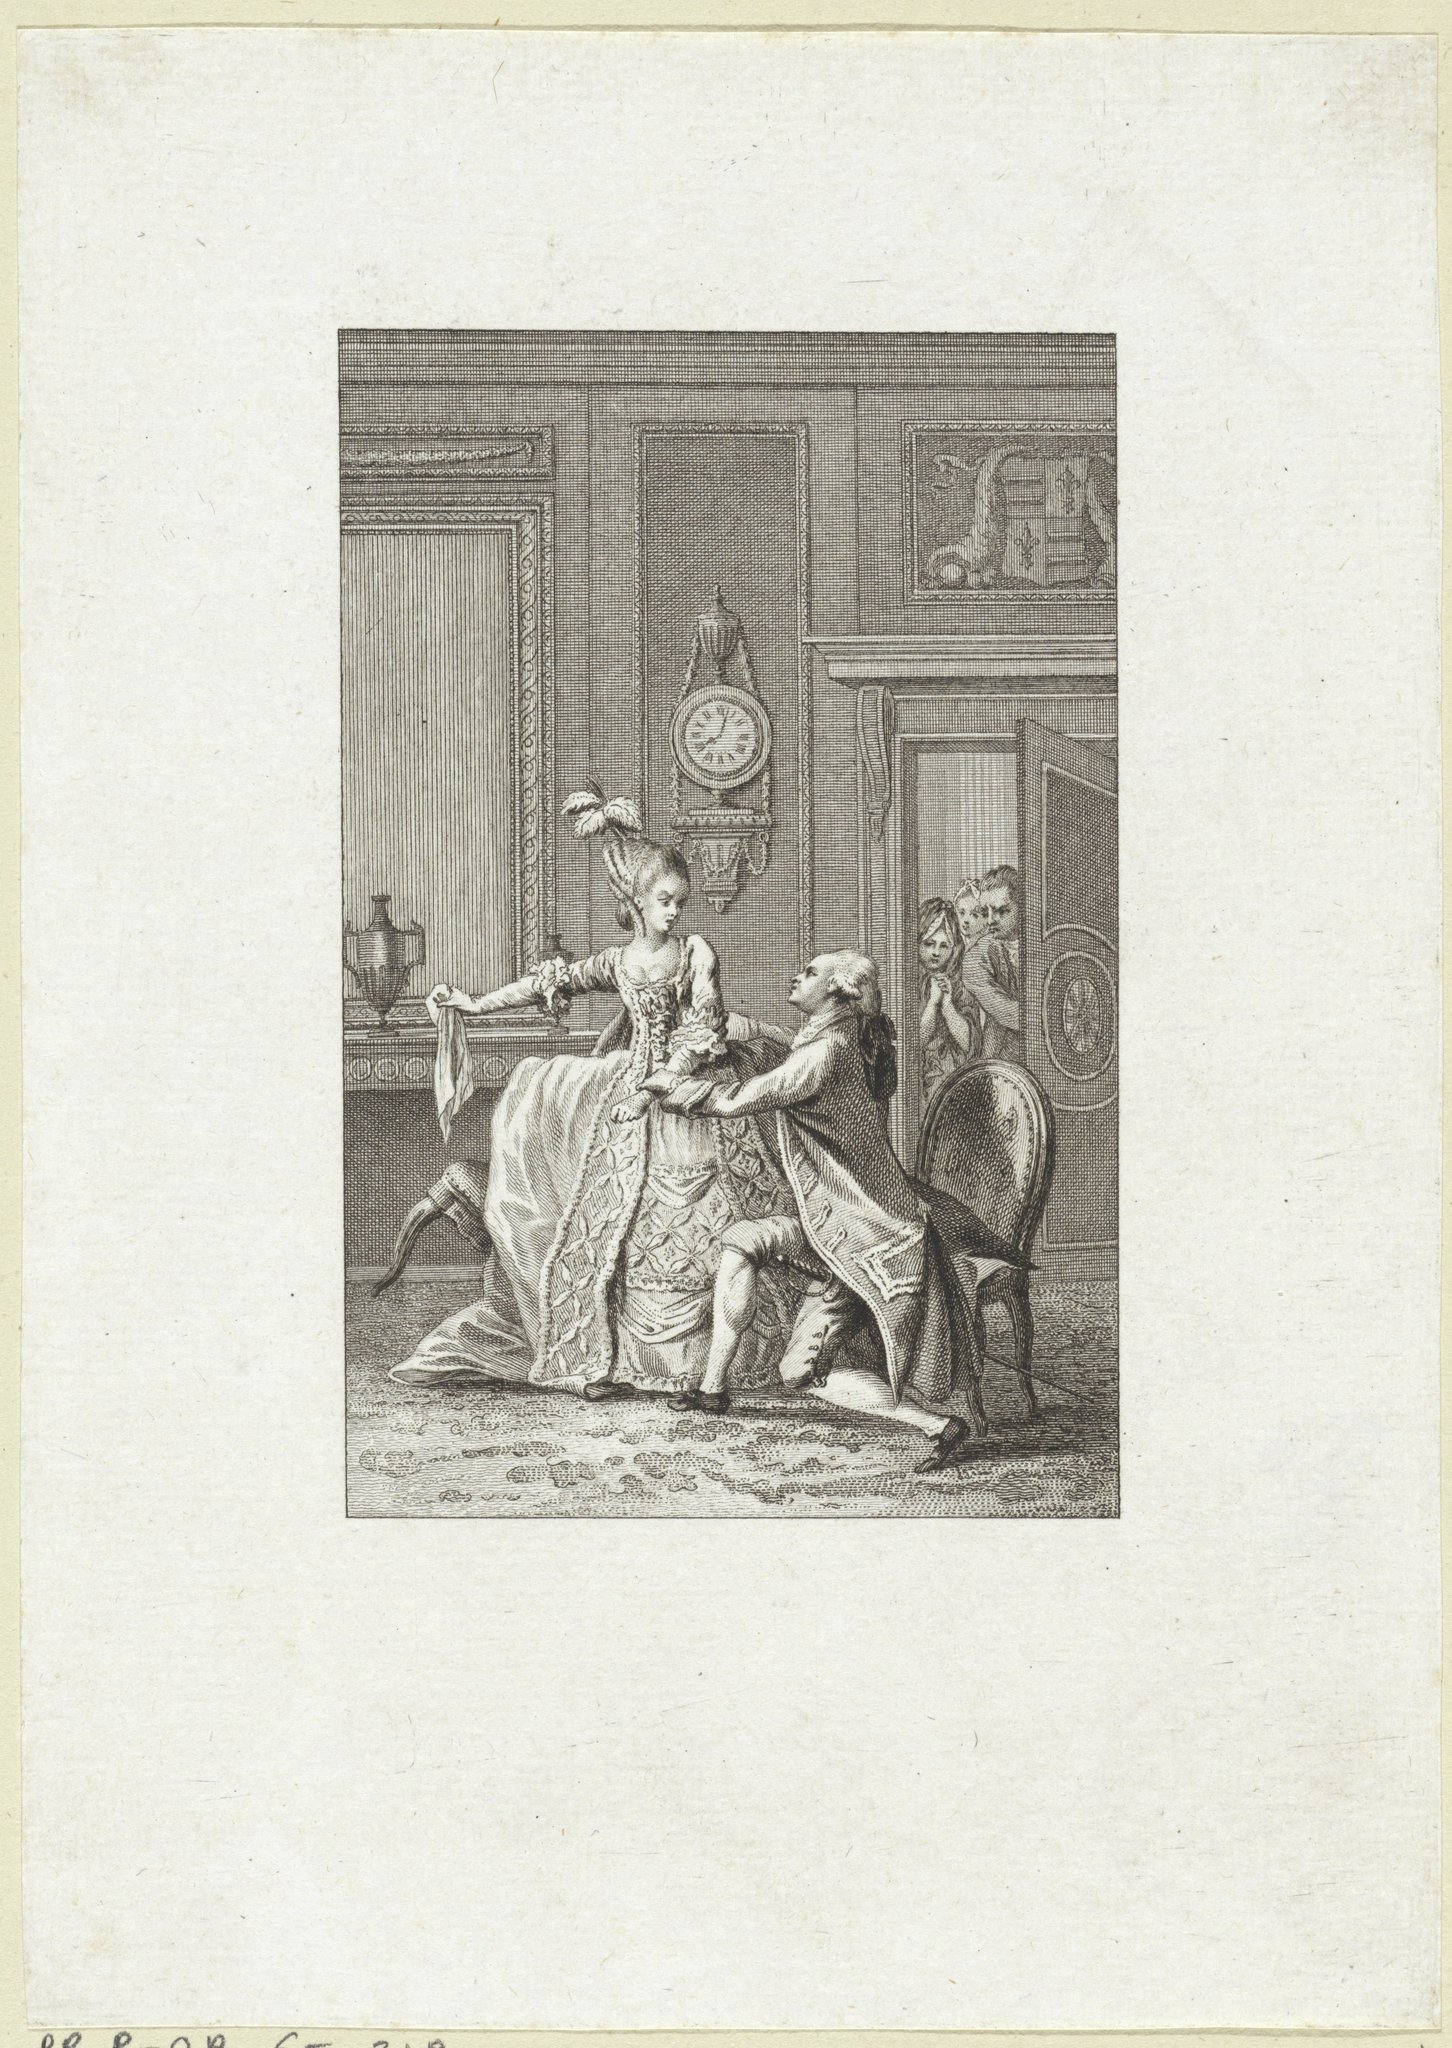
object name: print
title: Dame wijst een heer af terwijl figuren in de deuropening meeluisteren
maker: reinier vinkeles (i)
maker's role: draughtsman, print maker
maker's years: 1741-1816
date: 1777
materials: paper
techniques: engraving, etching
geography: amsterdam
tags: handkerchief, spying on someone, kneeling figure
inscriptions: collector's mark: Lugt 240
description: Proefdruk van illustratie die mogelijk is gebruikt in: De vrouw naar de waereld. Amsteldam: Isaak Duim, 1777.